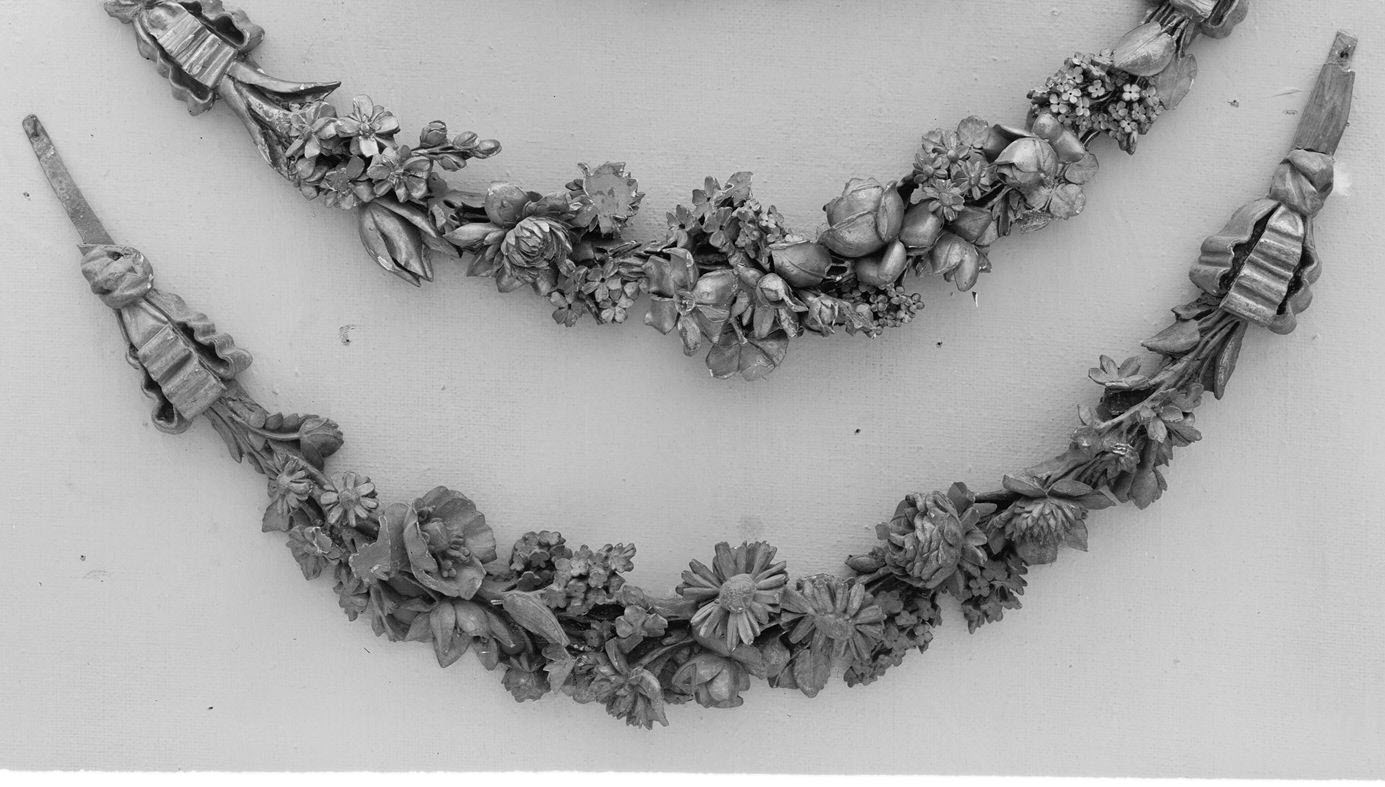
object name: garland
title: Garland (part of a set)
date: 1701-1800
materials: gilt, wood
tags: garlands